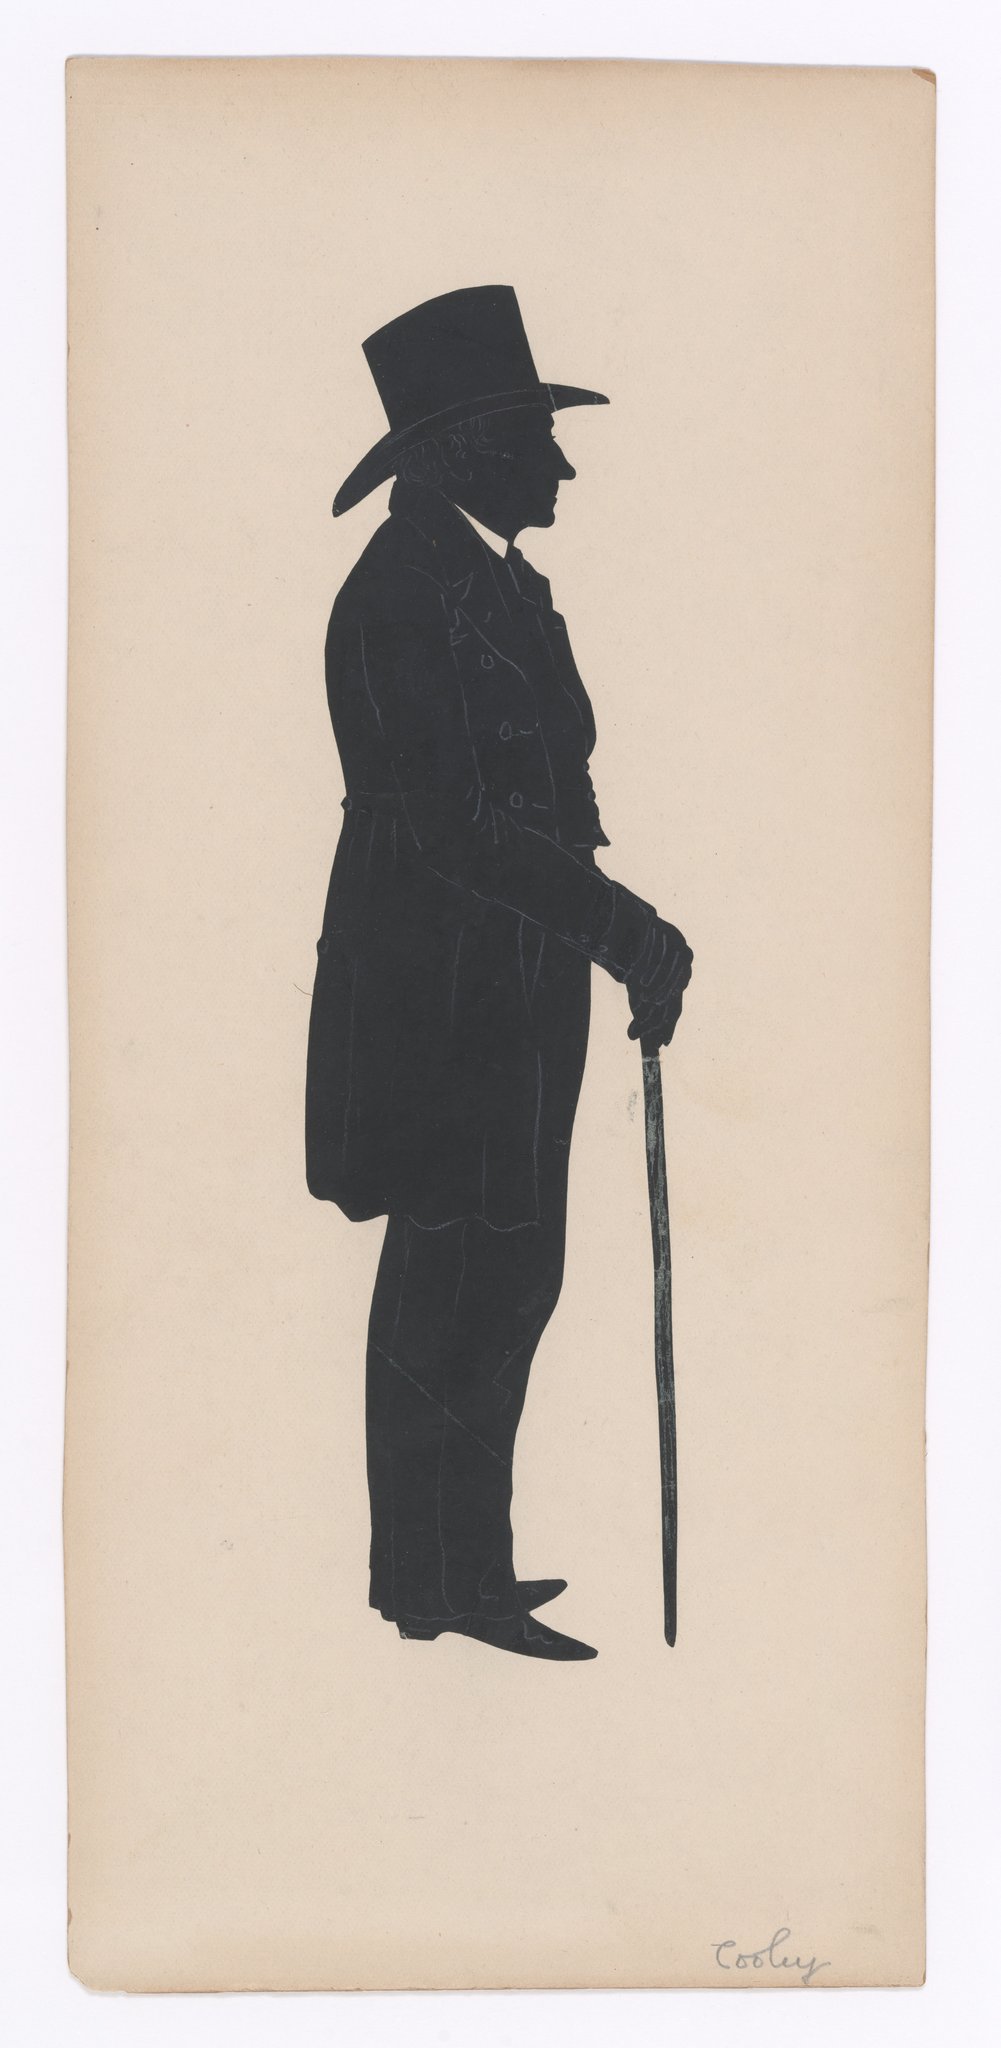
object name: cut paper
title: James Tooley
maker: auguste edouart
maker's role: artist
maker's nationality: french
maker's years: 1789-1861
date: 1844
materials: paper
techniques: cutting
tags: men